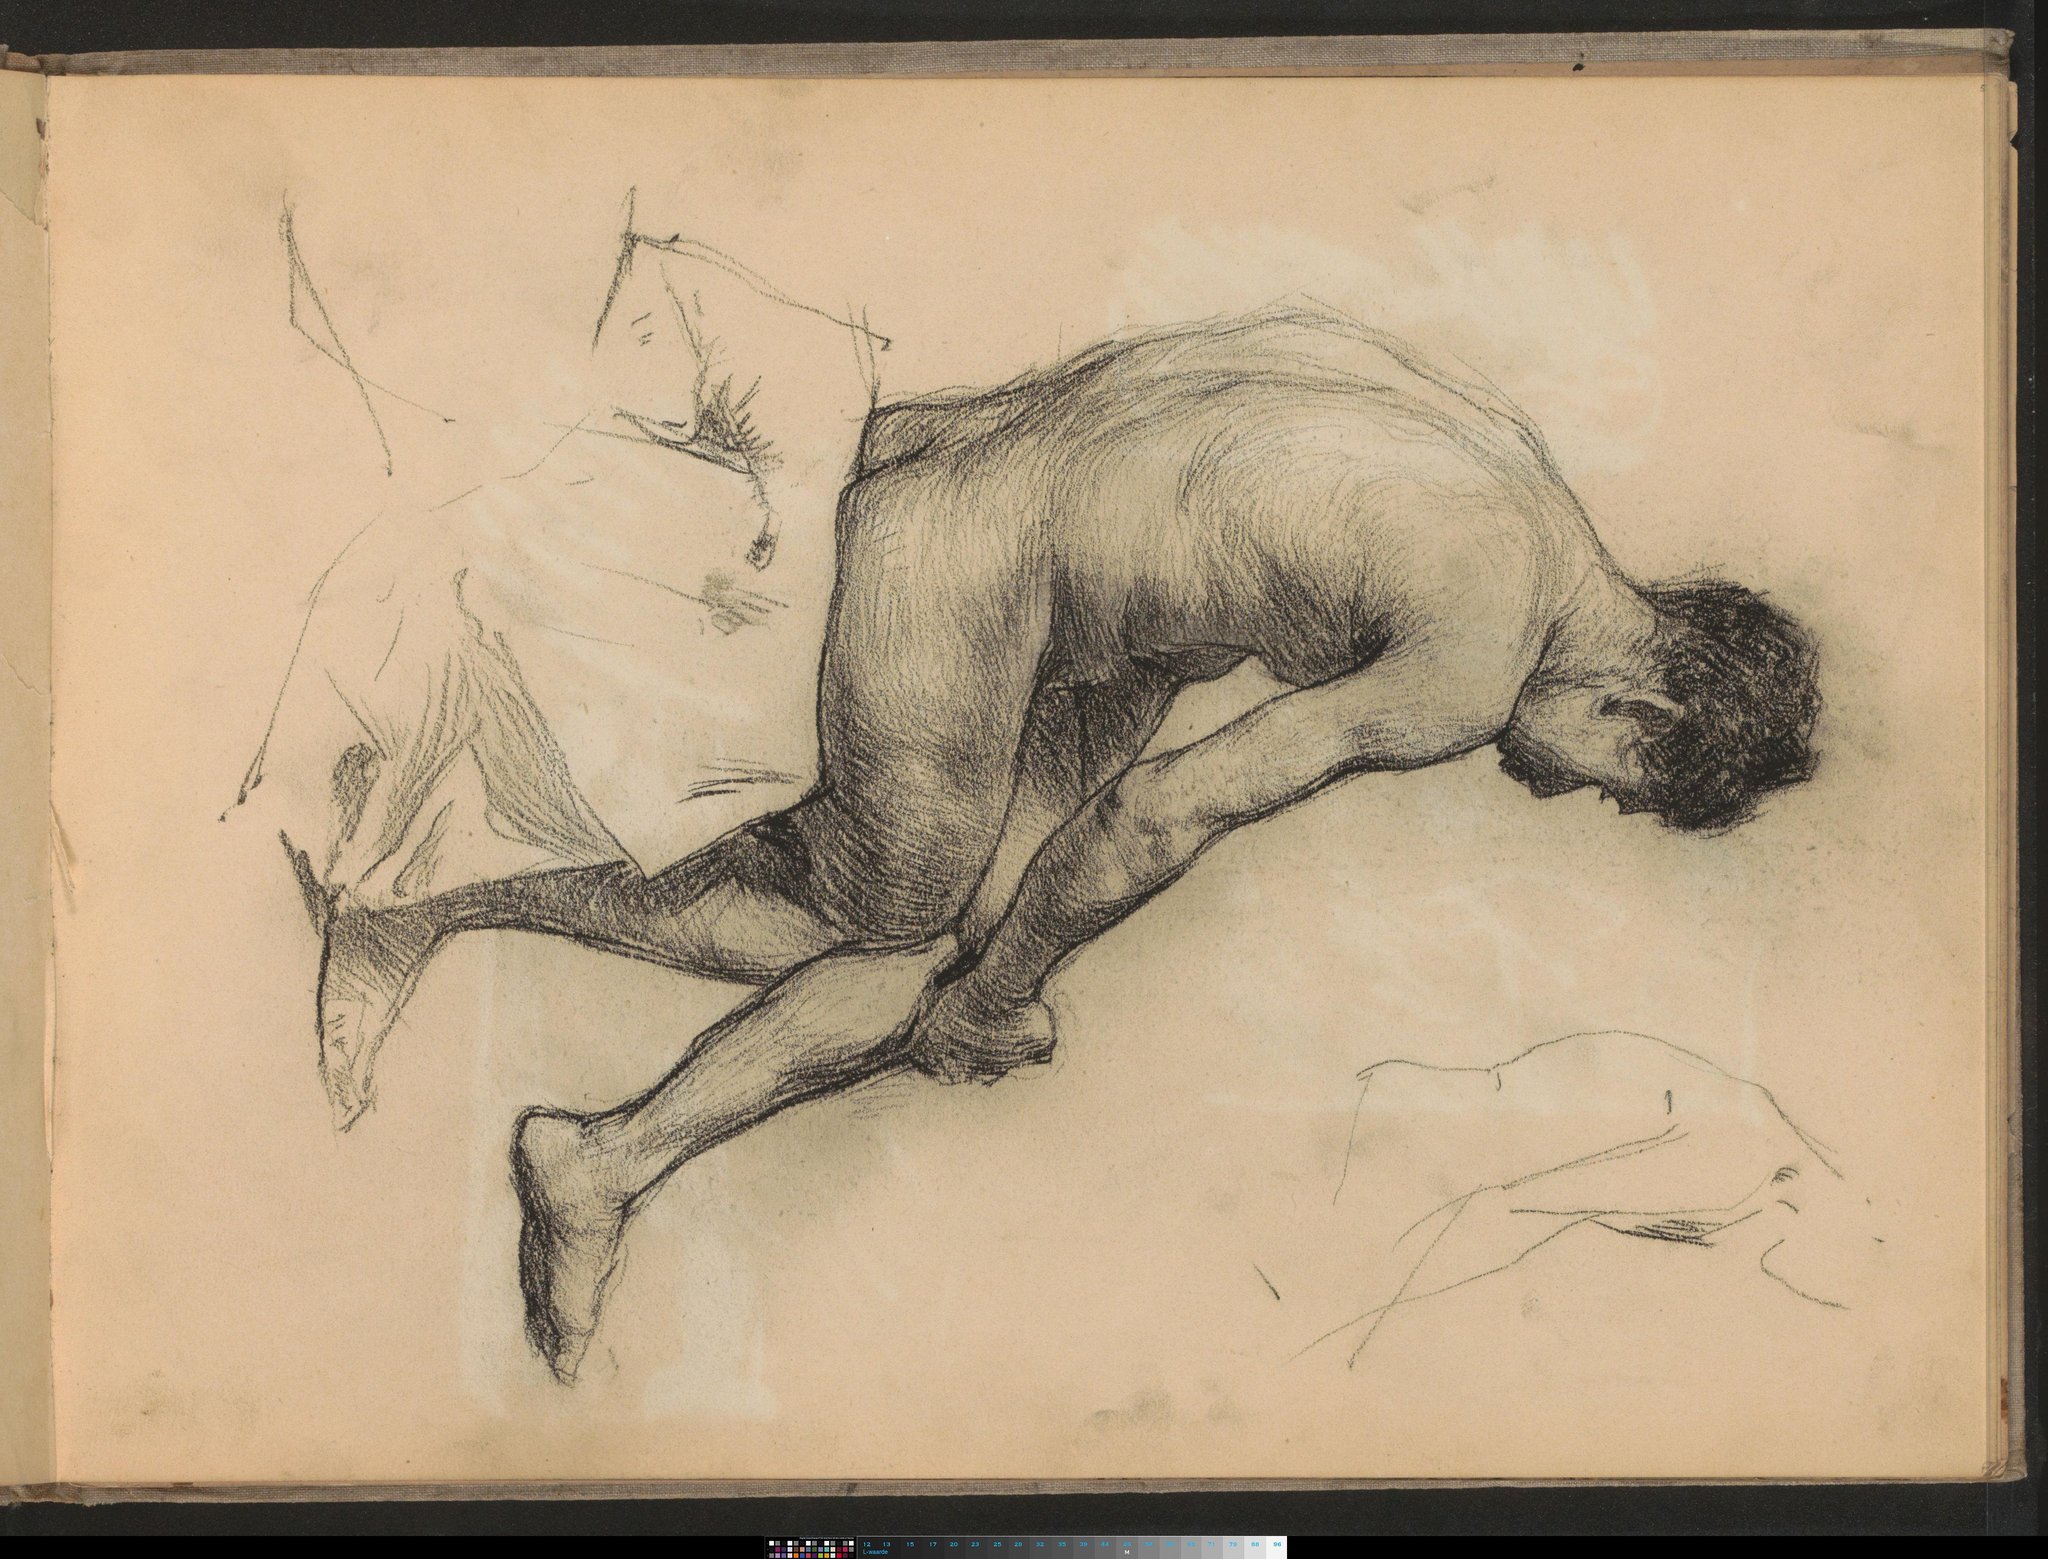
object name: sketchbook leaf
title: Zittende naakte man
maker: marius bauer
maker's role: draughtsman, print maker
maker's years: 1867-1932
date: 1887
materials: chalk, paper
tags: sitting figure, adult man, sitting cross-legged, as tailor at work, the (nude) human figure; 'corpo humano' (ripa) - aa - female human figure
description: Pagina 5 uit een schetsboek met 19 bladen.